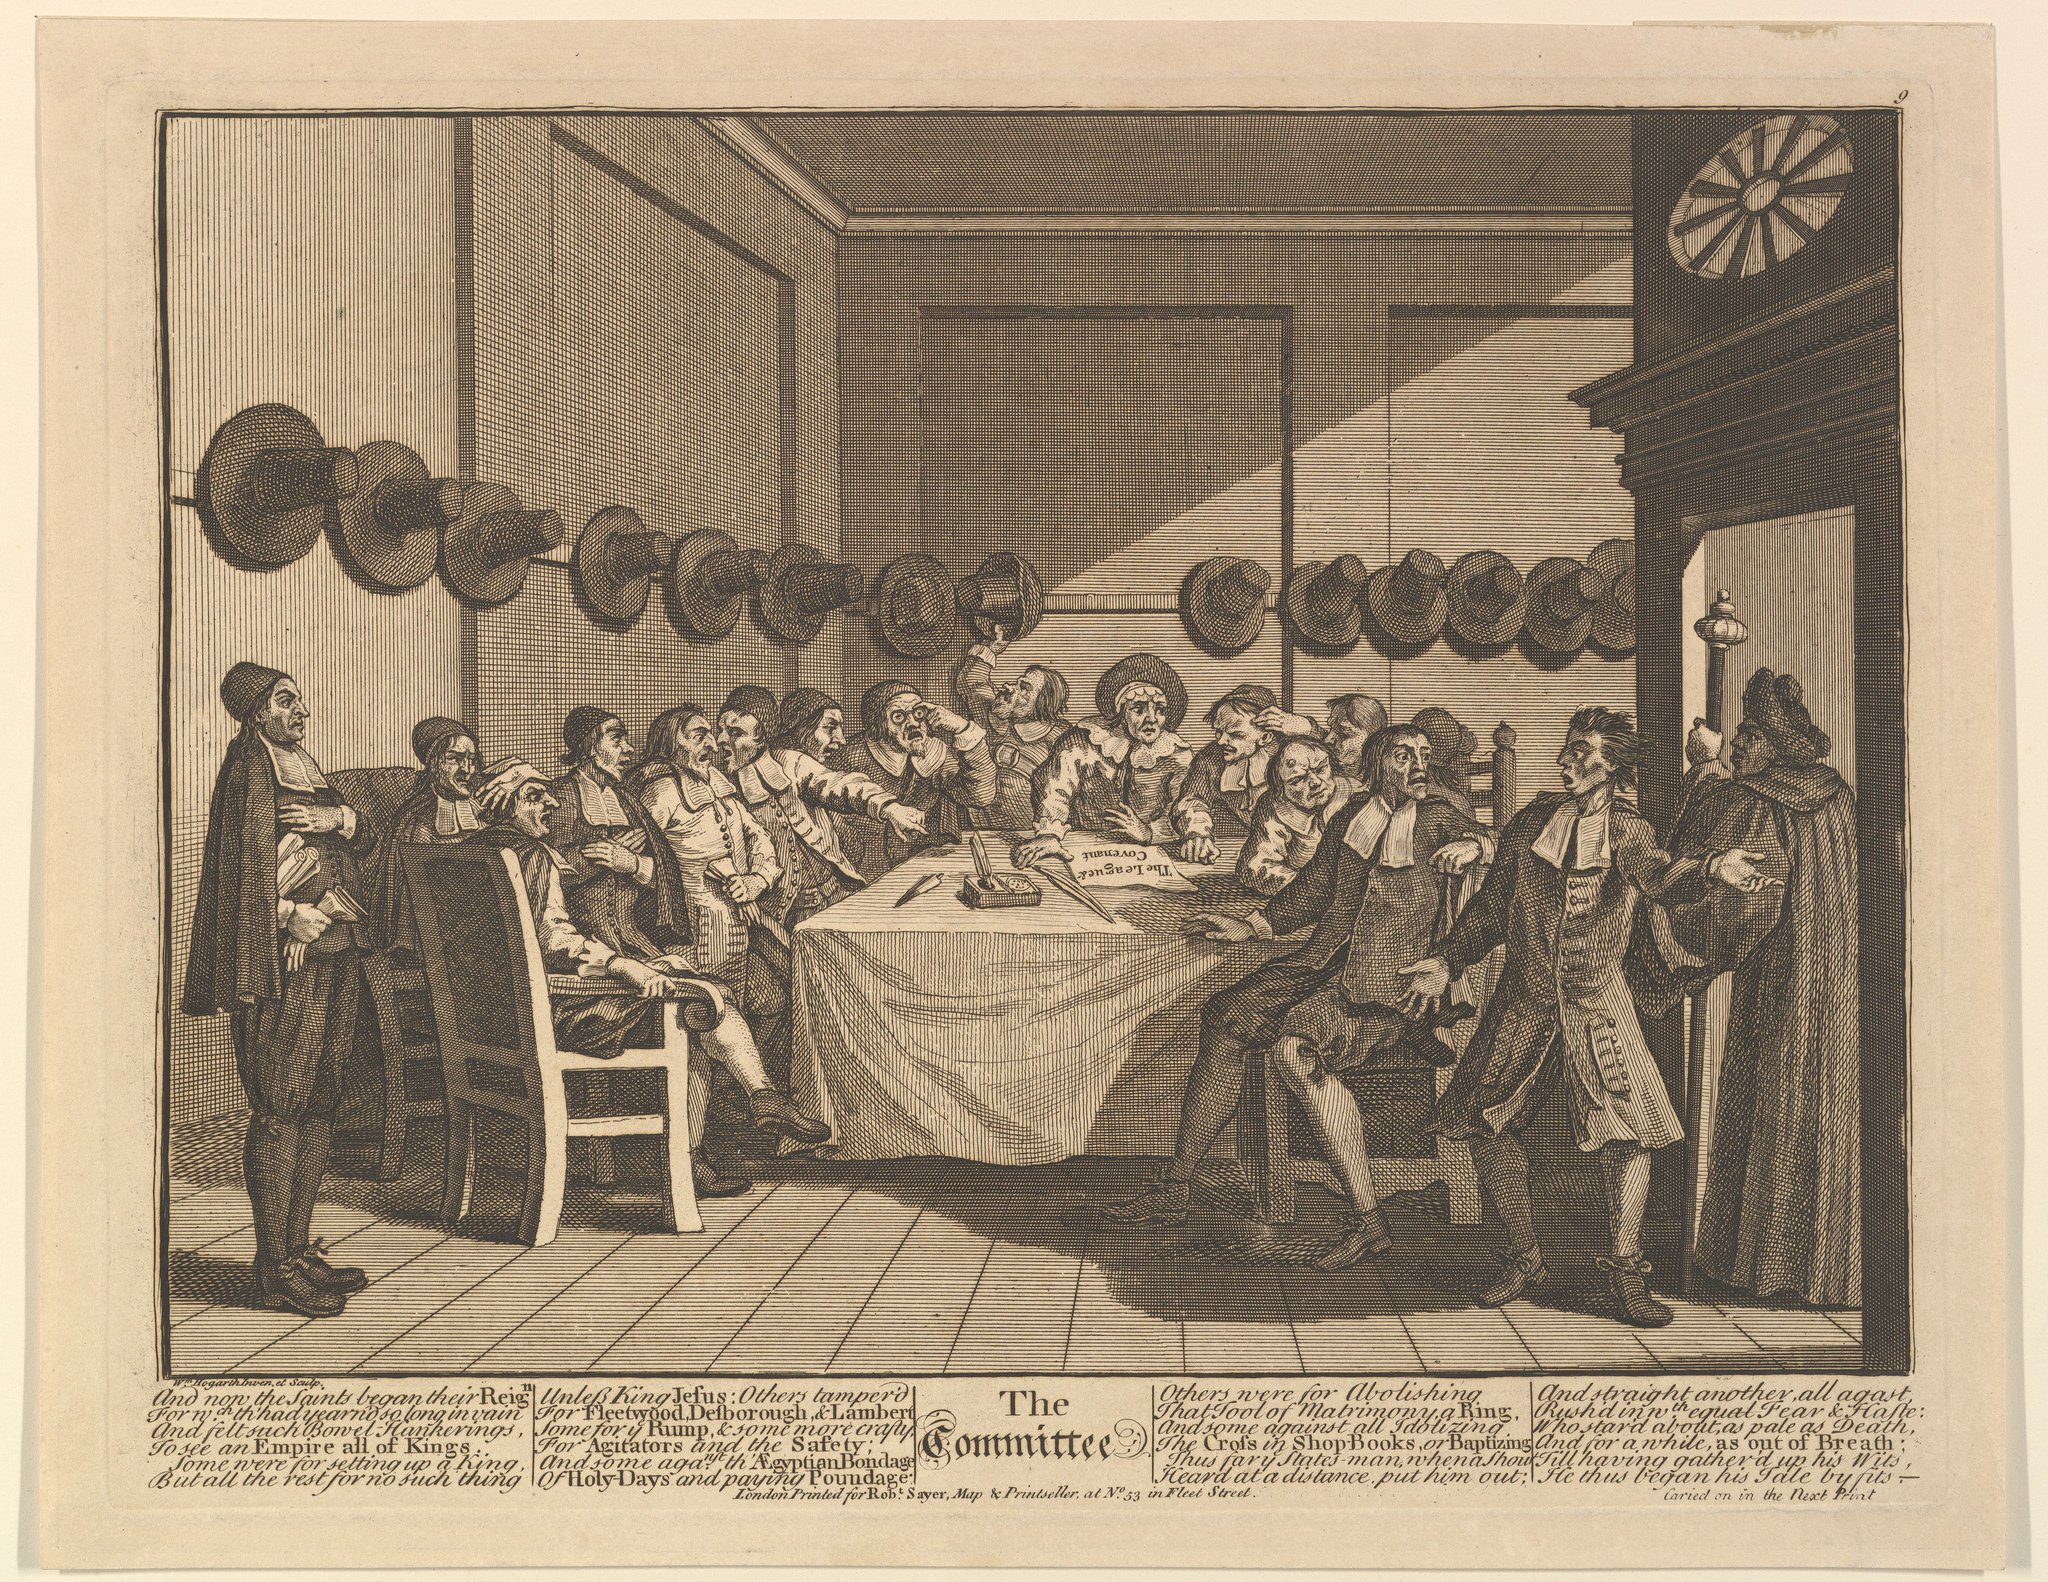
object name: print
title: The Committee (Twelve Large Illustrations for Samuel Butler's Hudbras, Plate 10)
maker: william hogarth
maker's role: artist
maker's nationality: british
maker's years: 1697-1764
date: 1725-1768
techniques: engraving, etching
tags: men,chairs,tables